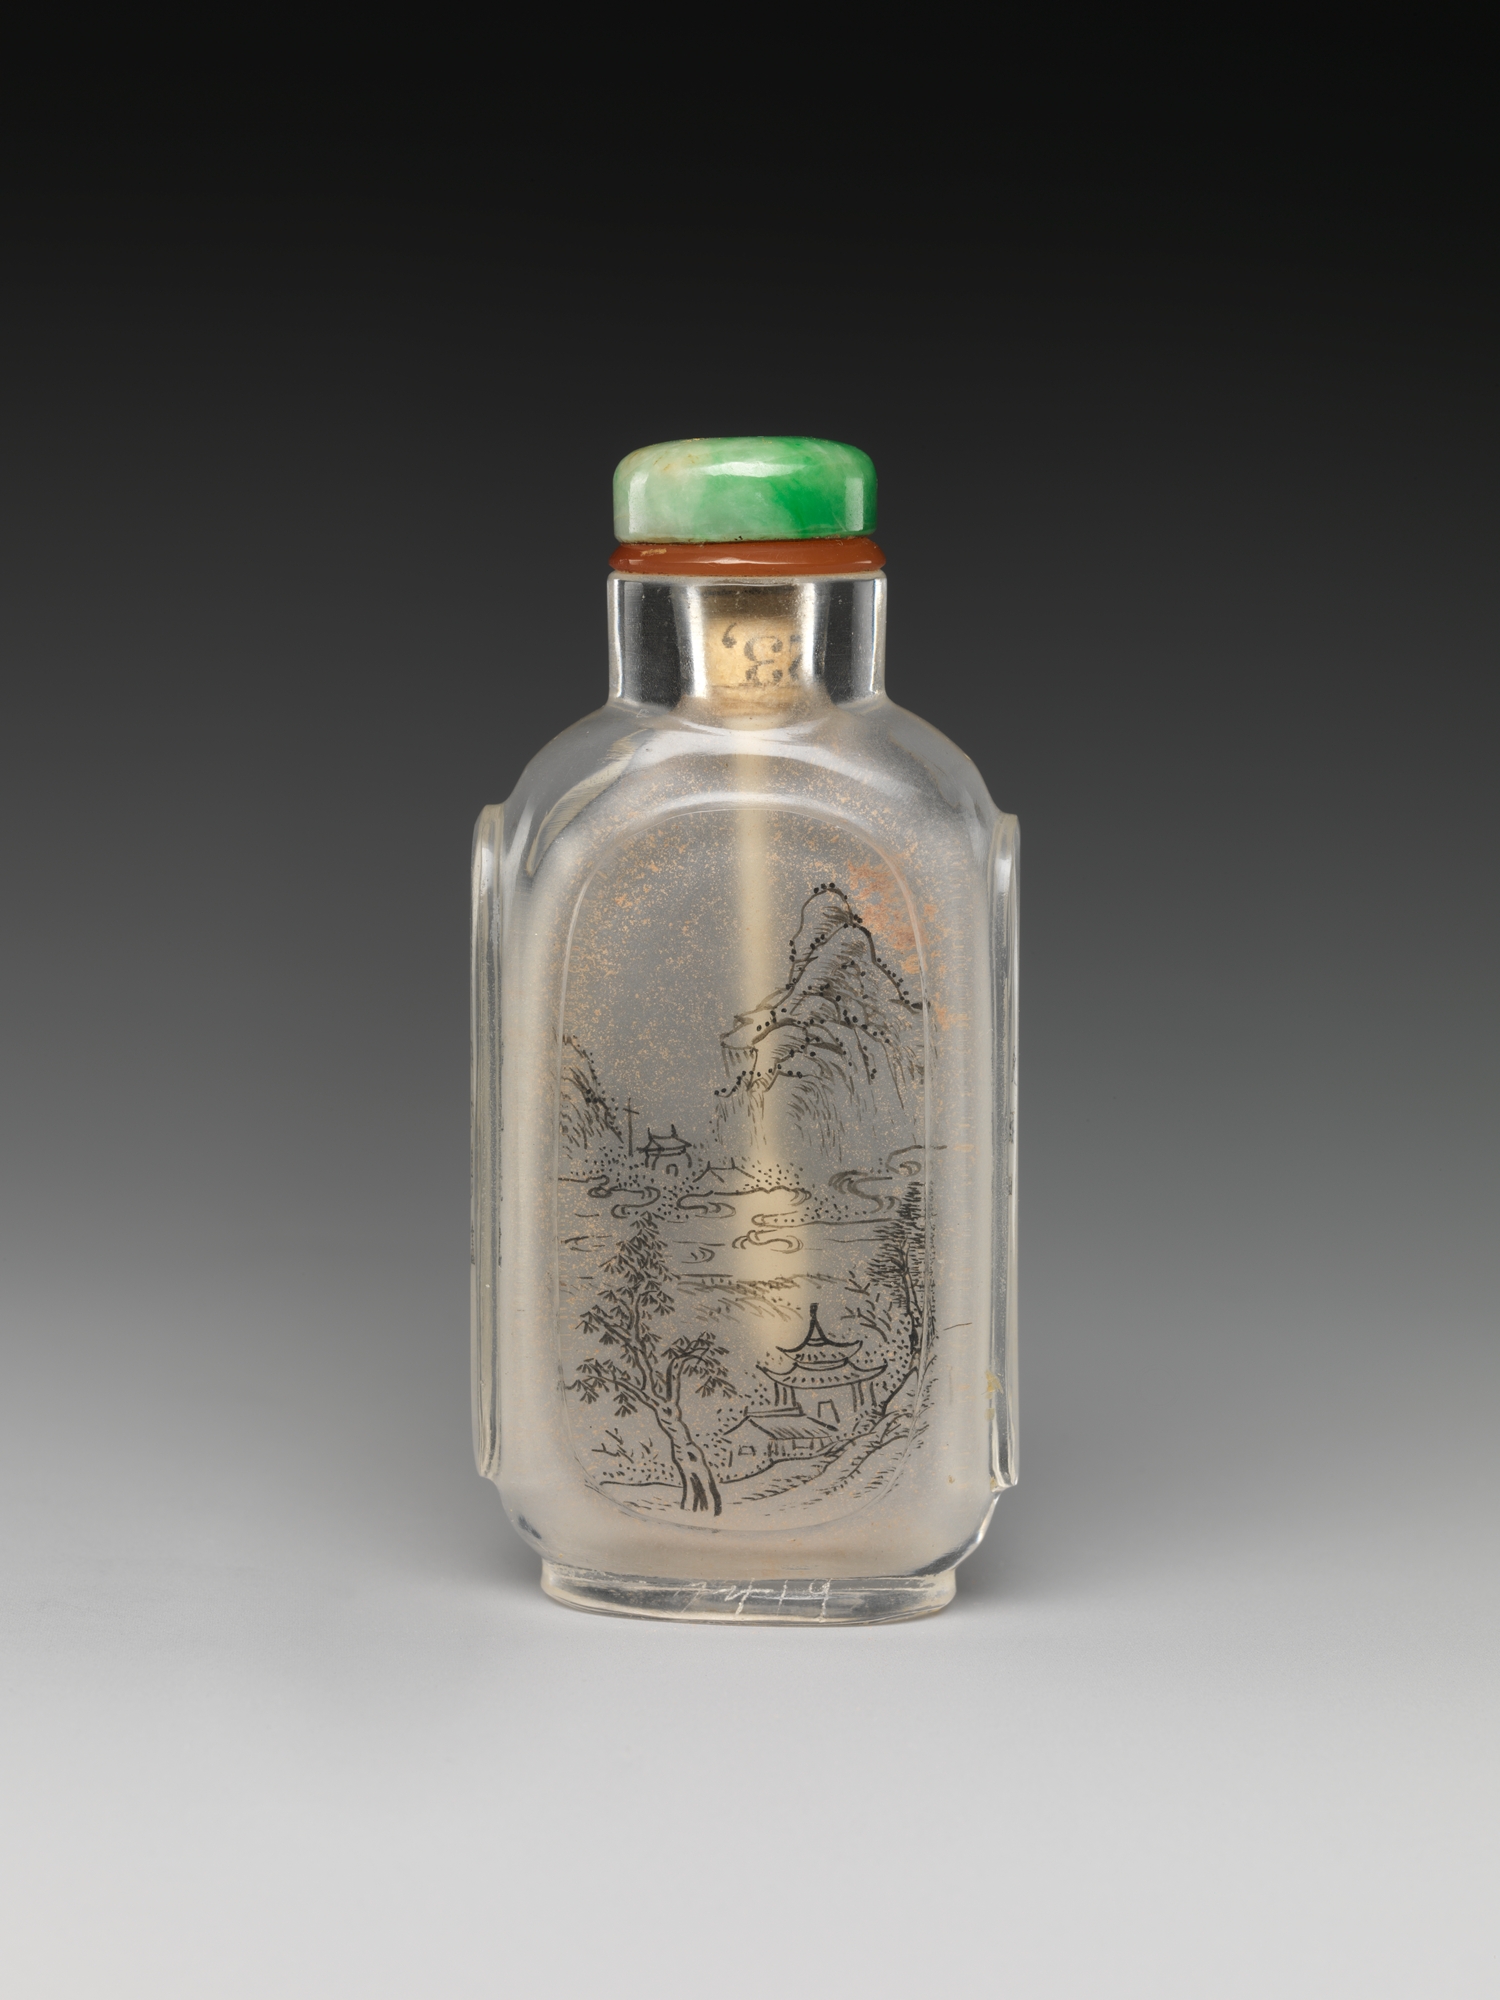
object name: snuff bottle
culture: chinese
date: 1851-1900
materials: quartz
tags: landscapes